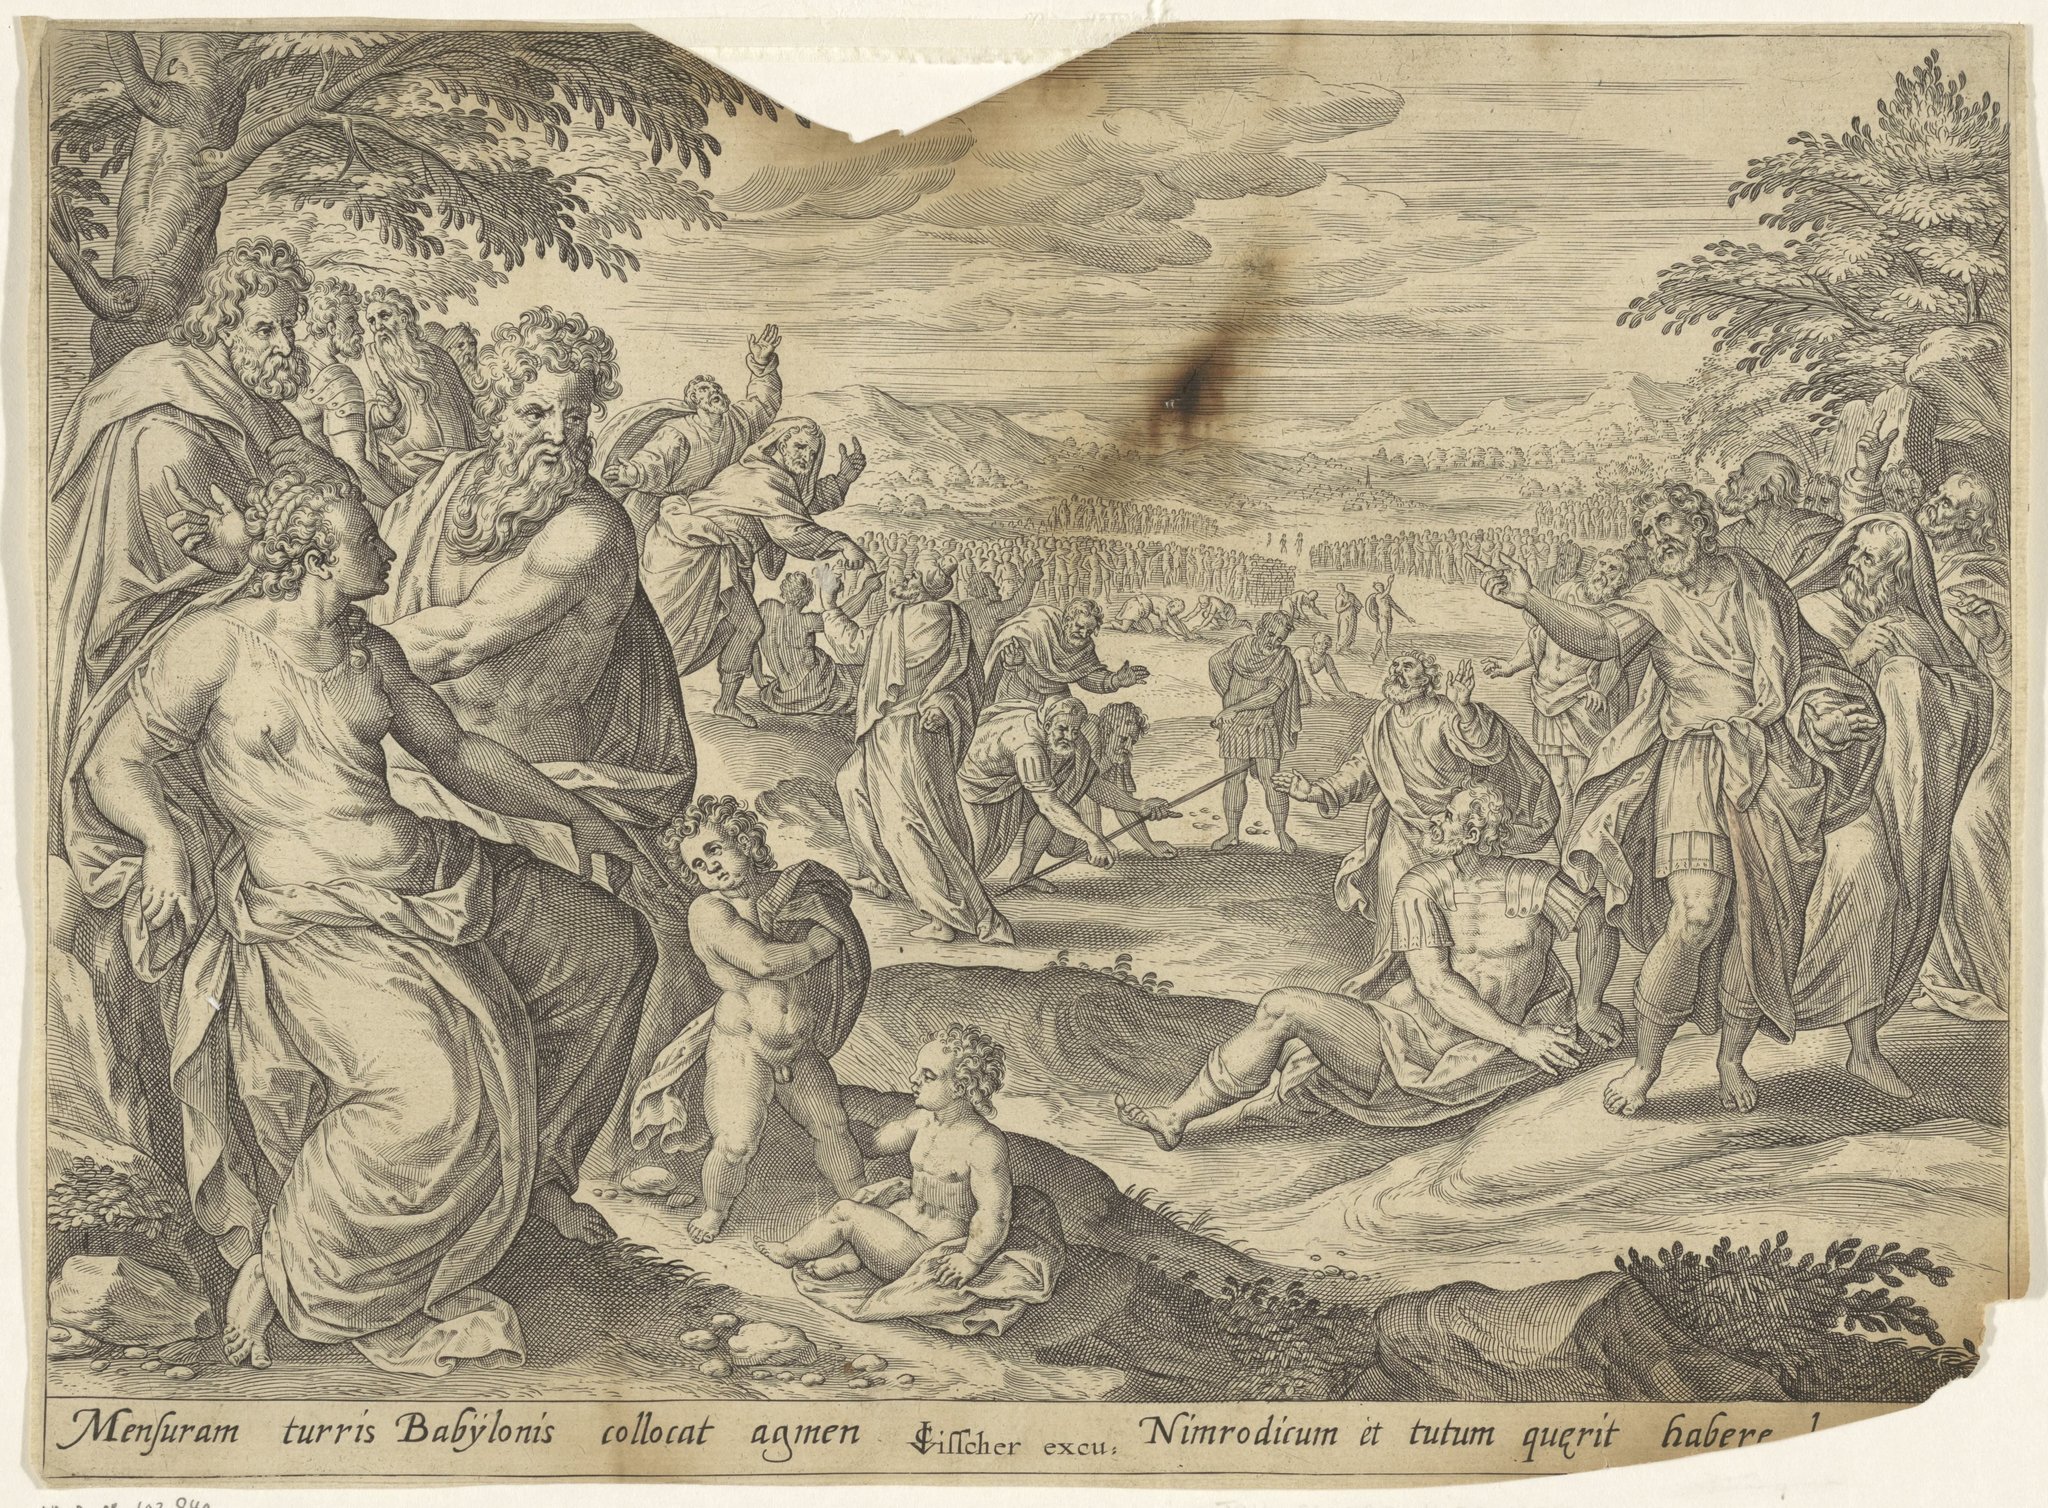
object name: print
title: Geschiedenis van de toren van Babel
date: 1643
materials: paper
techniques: engraving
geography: amsterdam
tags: the building of the tower of babel; nimrod may be present, supervising or assisting the construction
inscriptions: collector's mark: Lugt 2228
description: Prent gebruikt in: Theatrum biblicum : hoc est historiae sacrae veteris et novi testamenti tabulis aeneis expressae. Opus praesentatissimorum huius ac superioris seculi pictorum atque sculptorum, summo studio conquisitum et in lucem editum. Amsterdam: Claes Jansz. Visscher, 1643.